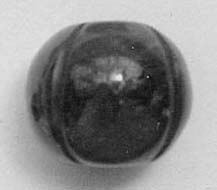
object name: bead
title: Five-Lobed Bead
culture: guatemala or mexico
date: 1902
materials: jade